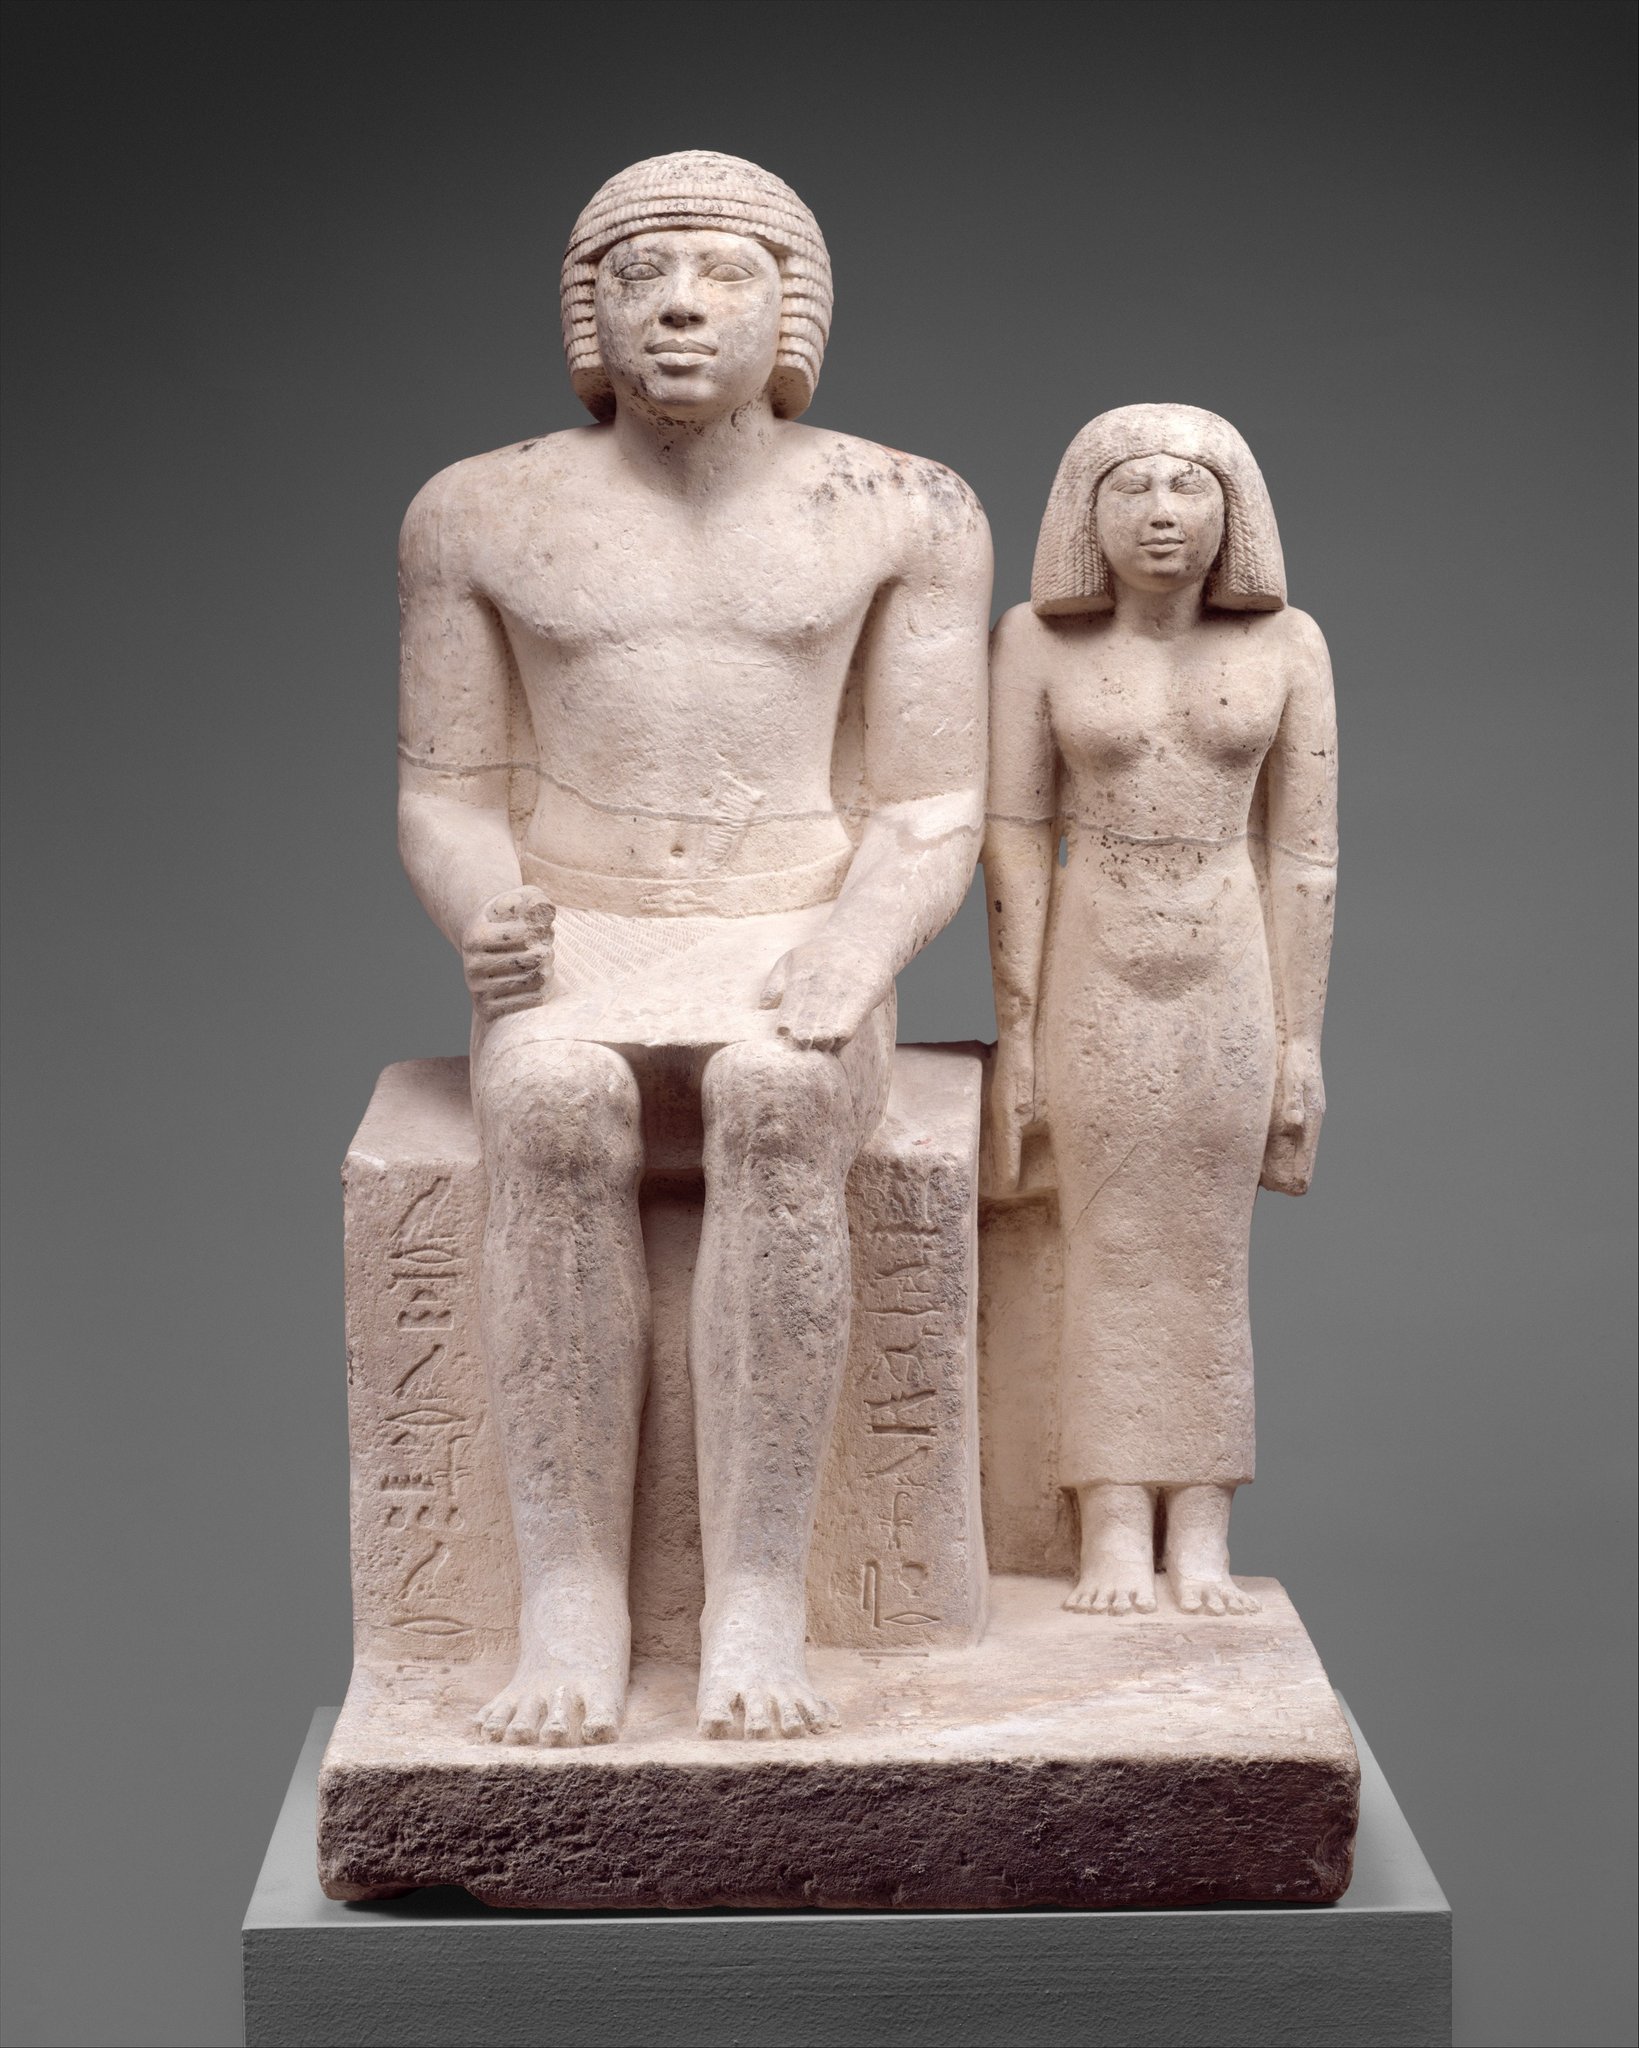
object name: statue, seated pair, demedji, hennutsen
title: Statue of Demedji and Hennutsen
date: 2465-2438 BCE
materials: limestone, paint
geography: memphite region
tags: men,women